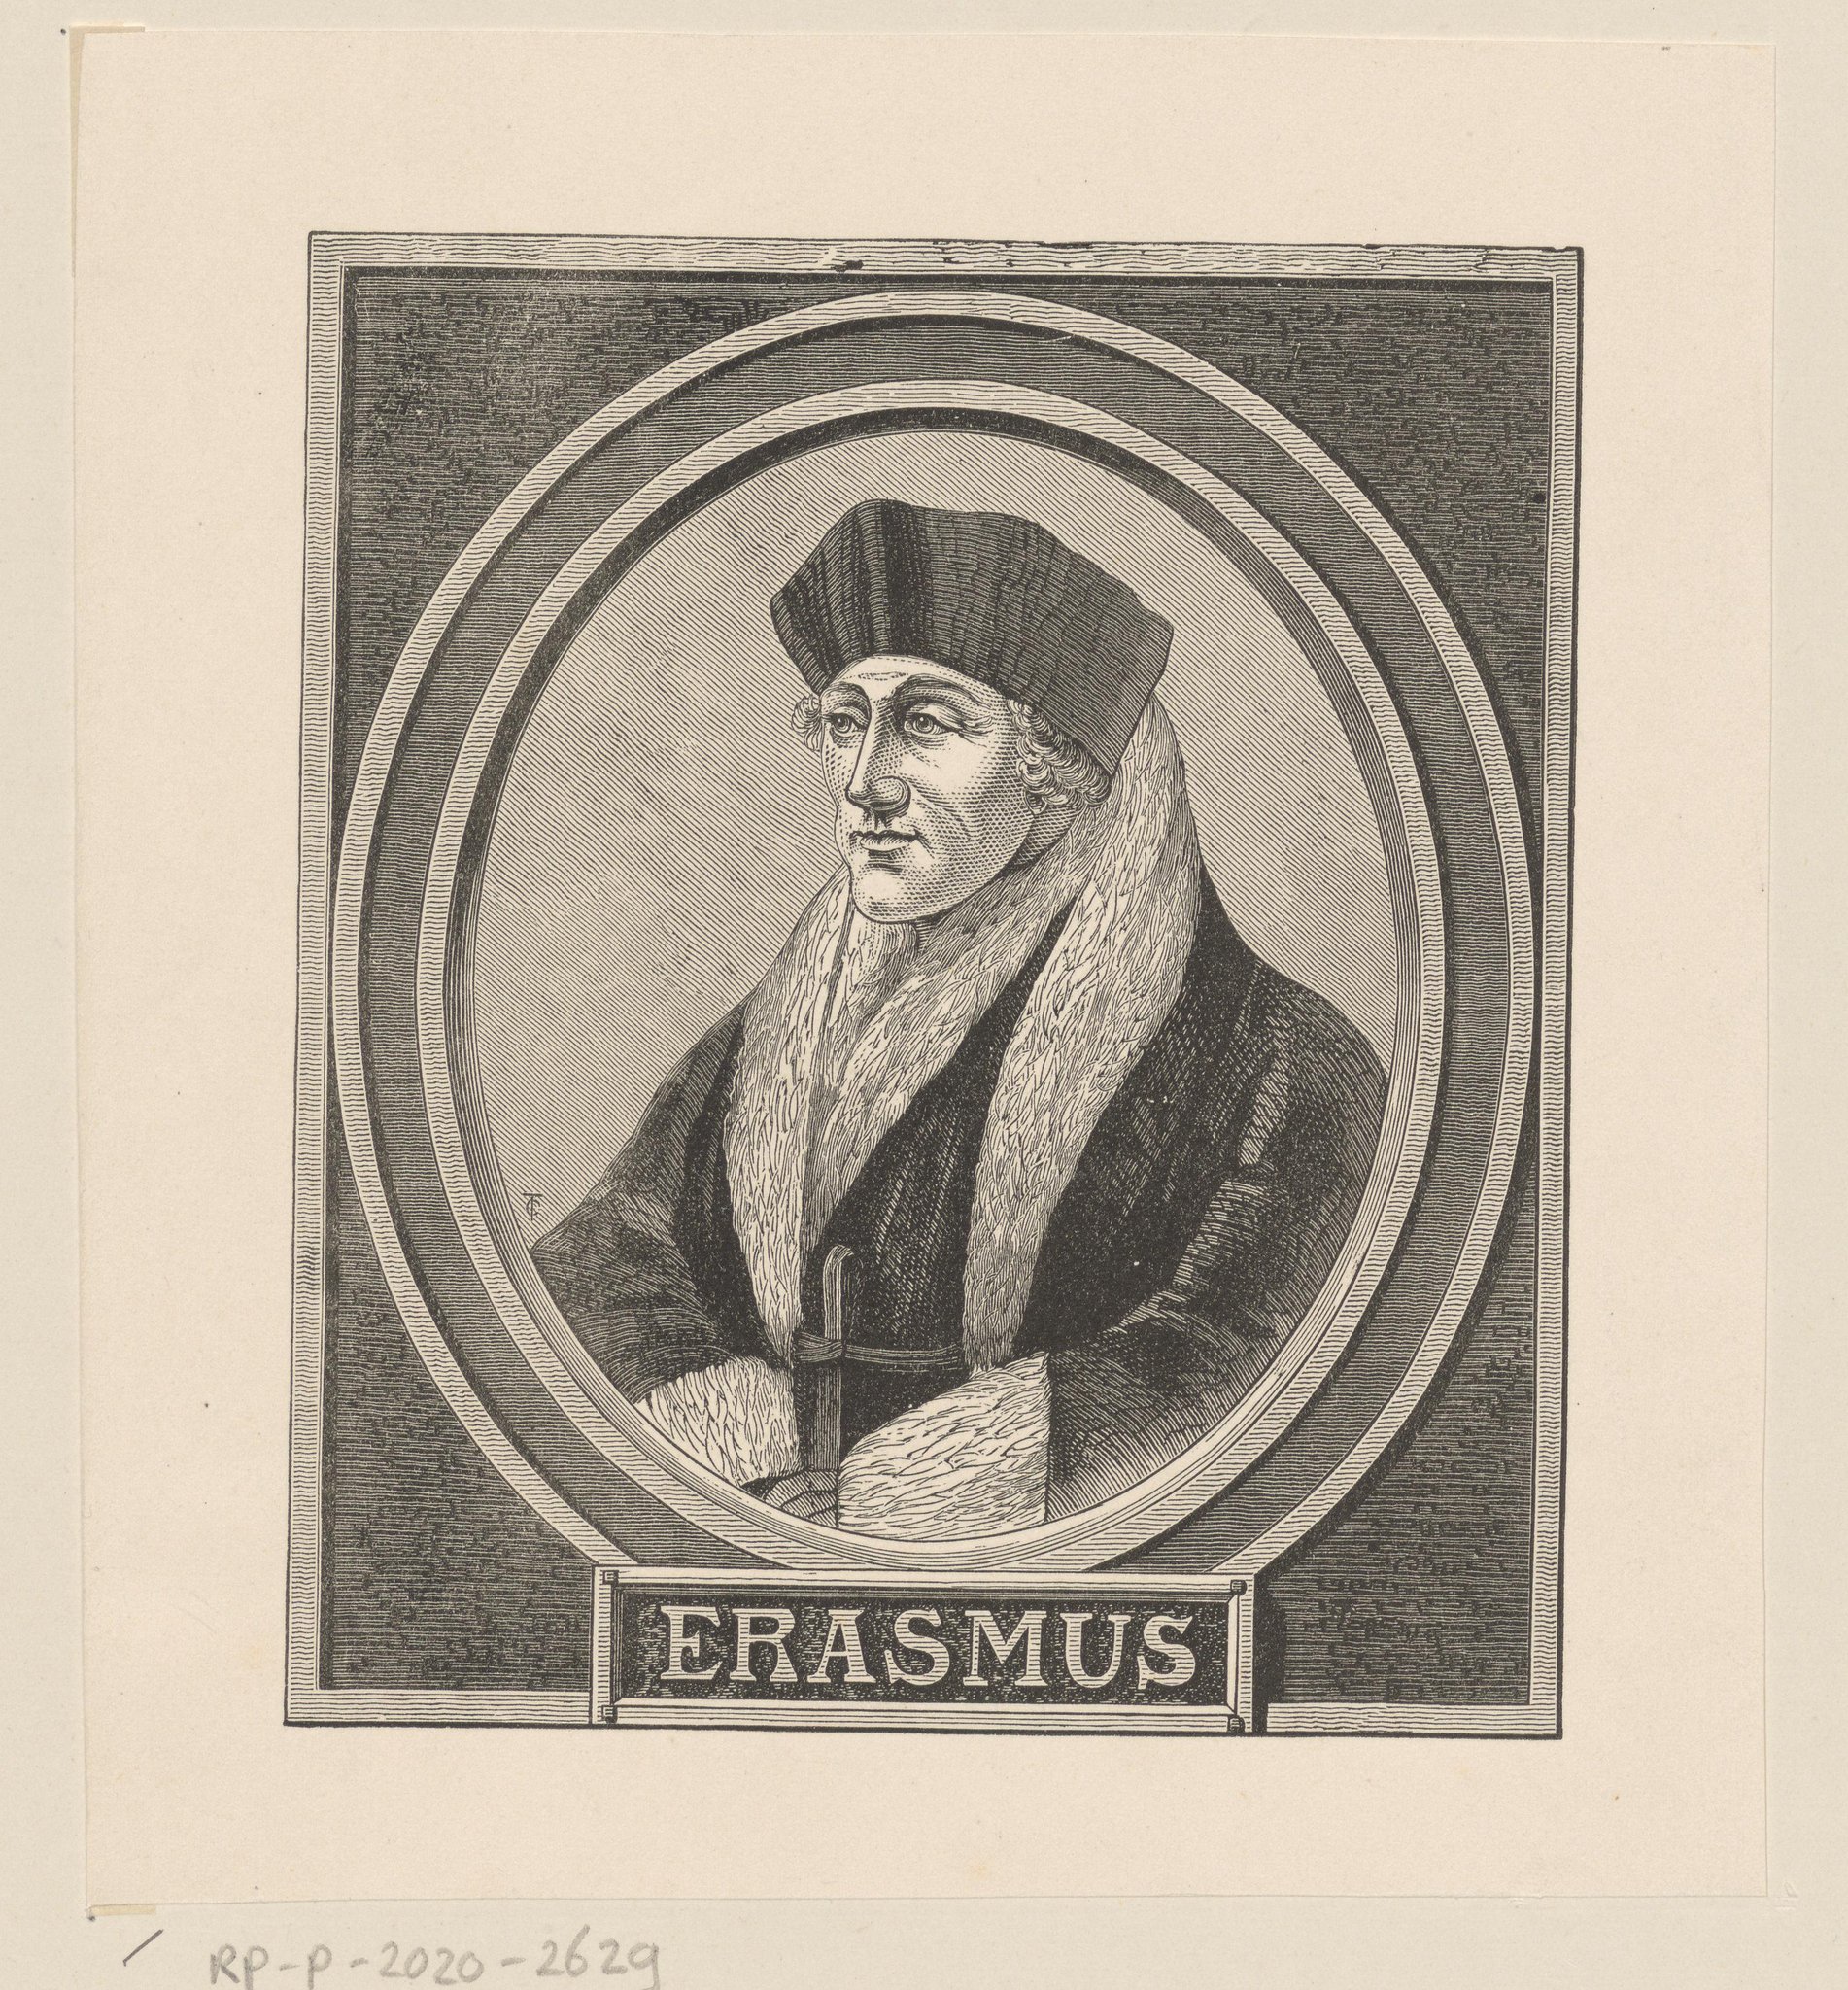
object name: print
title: Portret van Desiderius Erasmus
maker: Anonymous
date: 1800-1900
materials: paper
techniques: engraving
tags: desiderius erasmus, historical persons, scholar, philosopher (+ portrait of scholar, scientist)